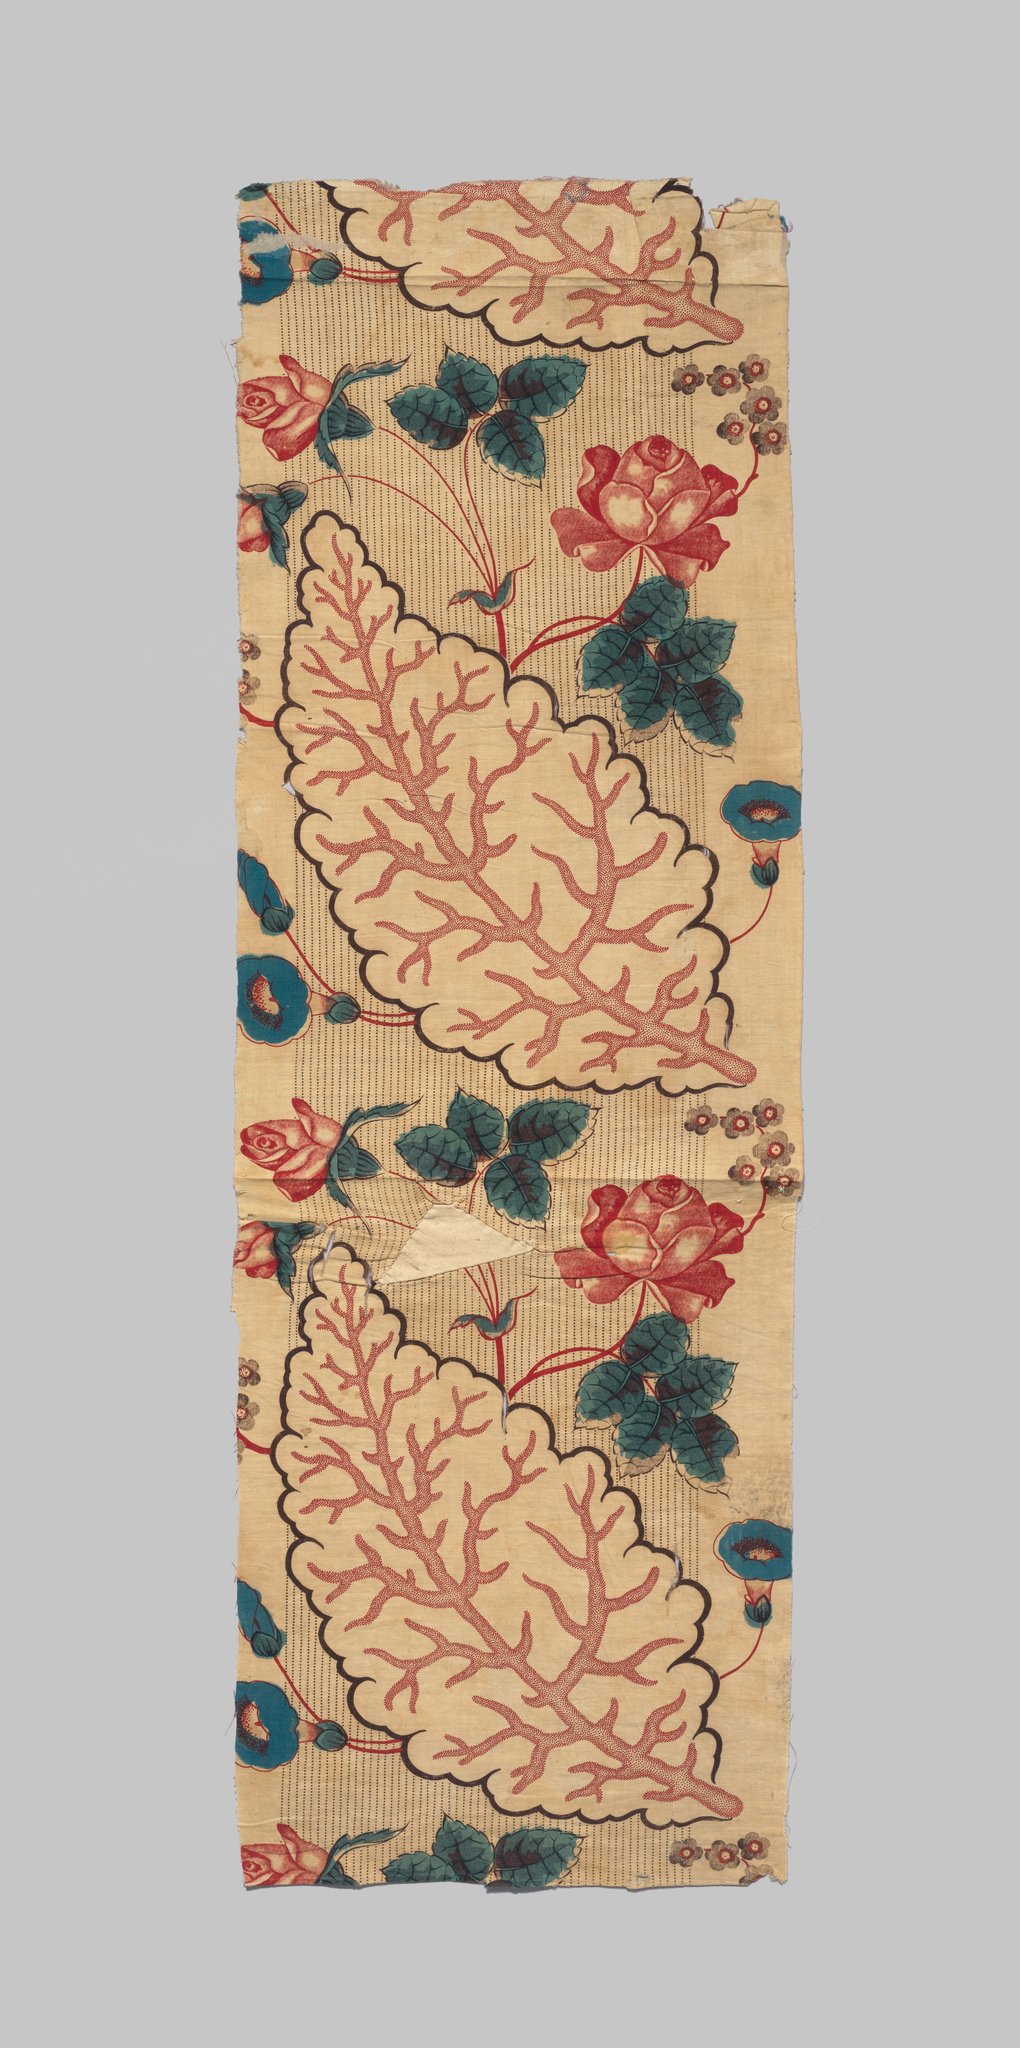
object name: piece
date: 1840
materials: cotton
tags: roses,leaves